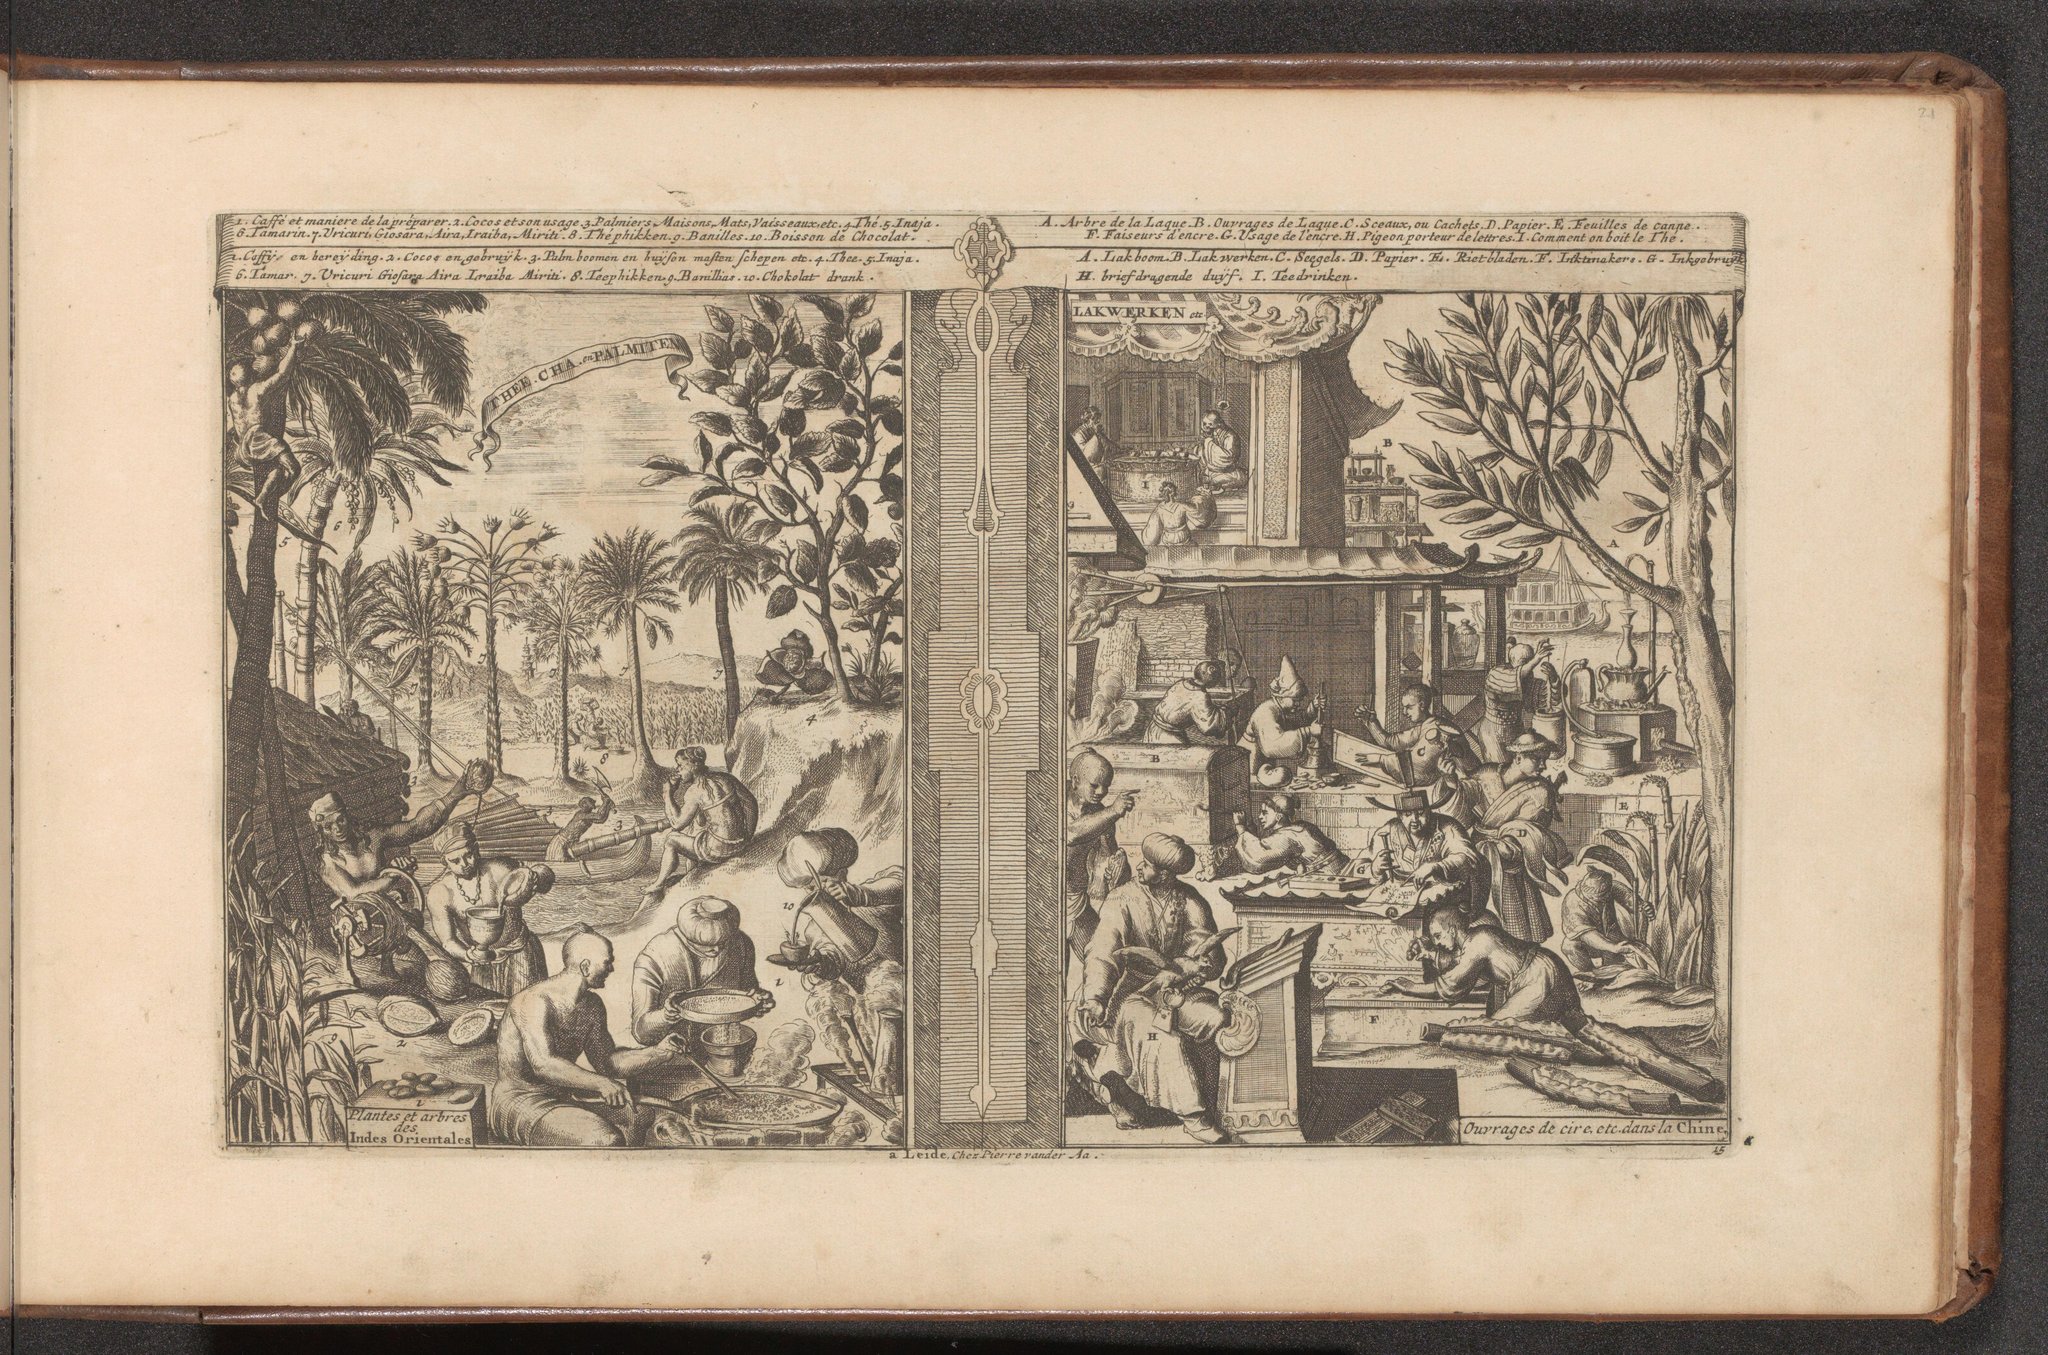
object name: album leaf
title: Les Indes Orientales et Occidentales et autres lieux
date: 1682-1733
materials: paper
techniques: etching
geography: leiden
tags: coffee, lacquering ~ applied arts, drinks, stimulants, drugs, tea (leaves), paper (writing material), china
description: Voorstelling in twee delen. Links de bereiding van kokosdrank, koffie en chocolade. Een man plukt kokosnoten uit een boom. Op de achtergrond een theeplantage. Op de andere voorstelling het lakwerk uit China met een lakboom en lakwerkers. Daarbij de productie en het gebruik van papier. Rechts de rietbladen die als vezels voor het papier werden gebruikt. De man ernaast heeft enkele lakzegels en papierbladen in zijn handen. Een andere man zit bij een lakkist en schrijft met inkt op papier. Op de voorgrond een inktmaker en een man met een briefdragende duif in zijn handen. Met een legenda in het Nederlands en het Frans. De prent maakt deel uit van een album.